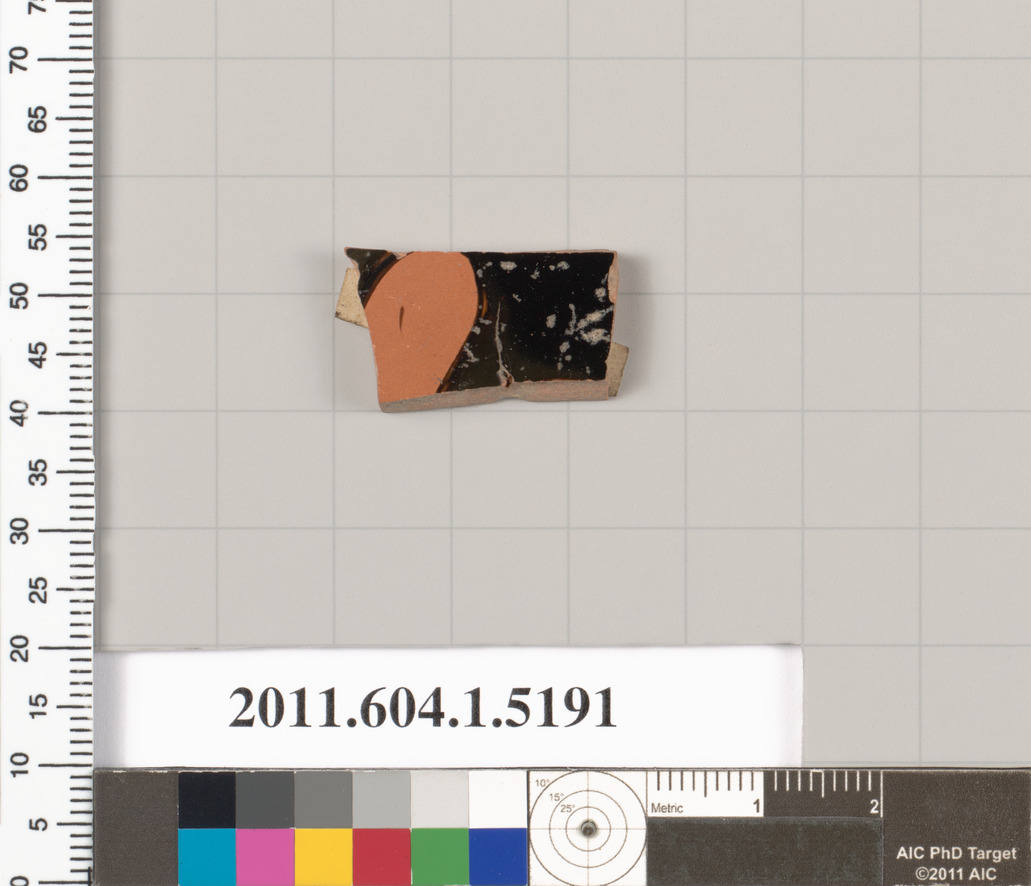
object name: kylix fragment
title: Terracotta fragment of a kylix (drinking cup)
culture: greek, attic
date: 500-480 BCE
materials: terracotta